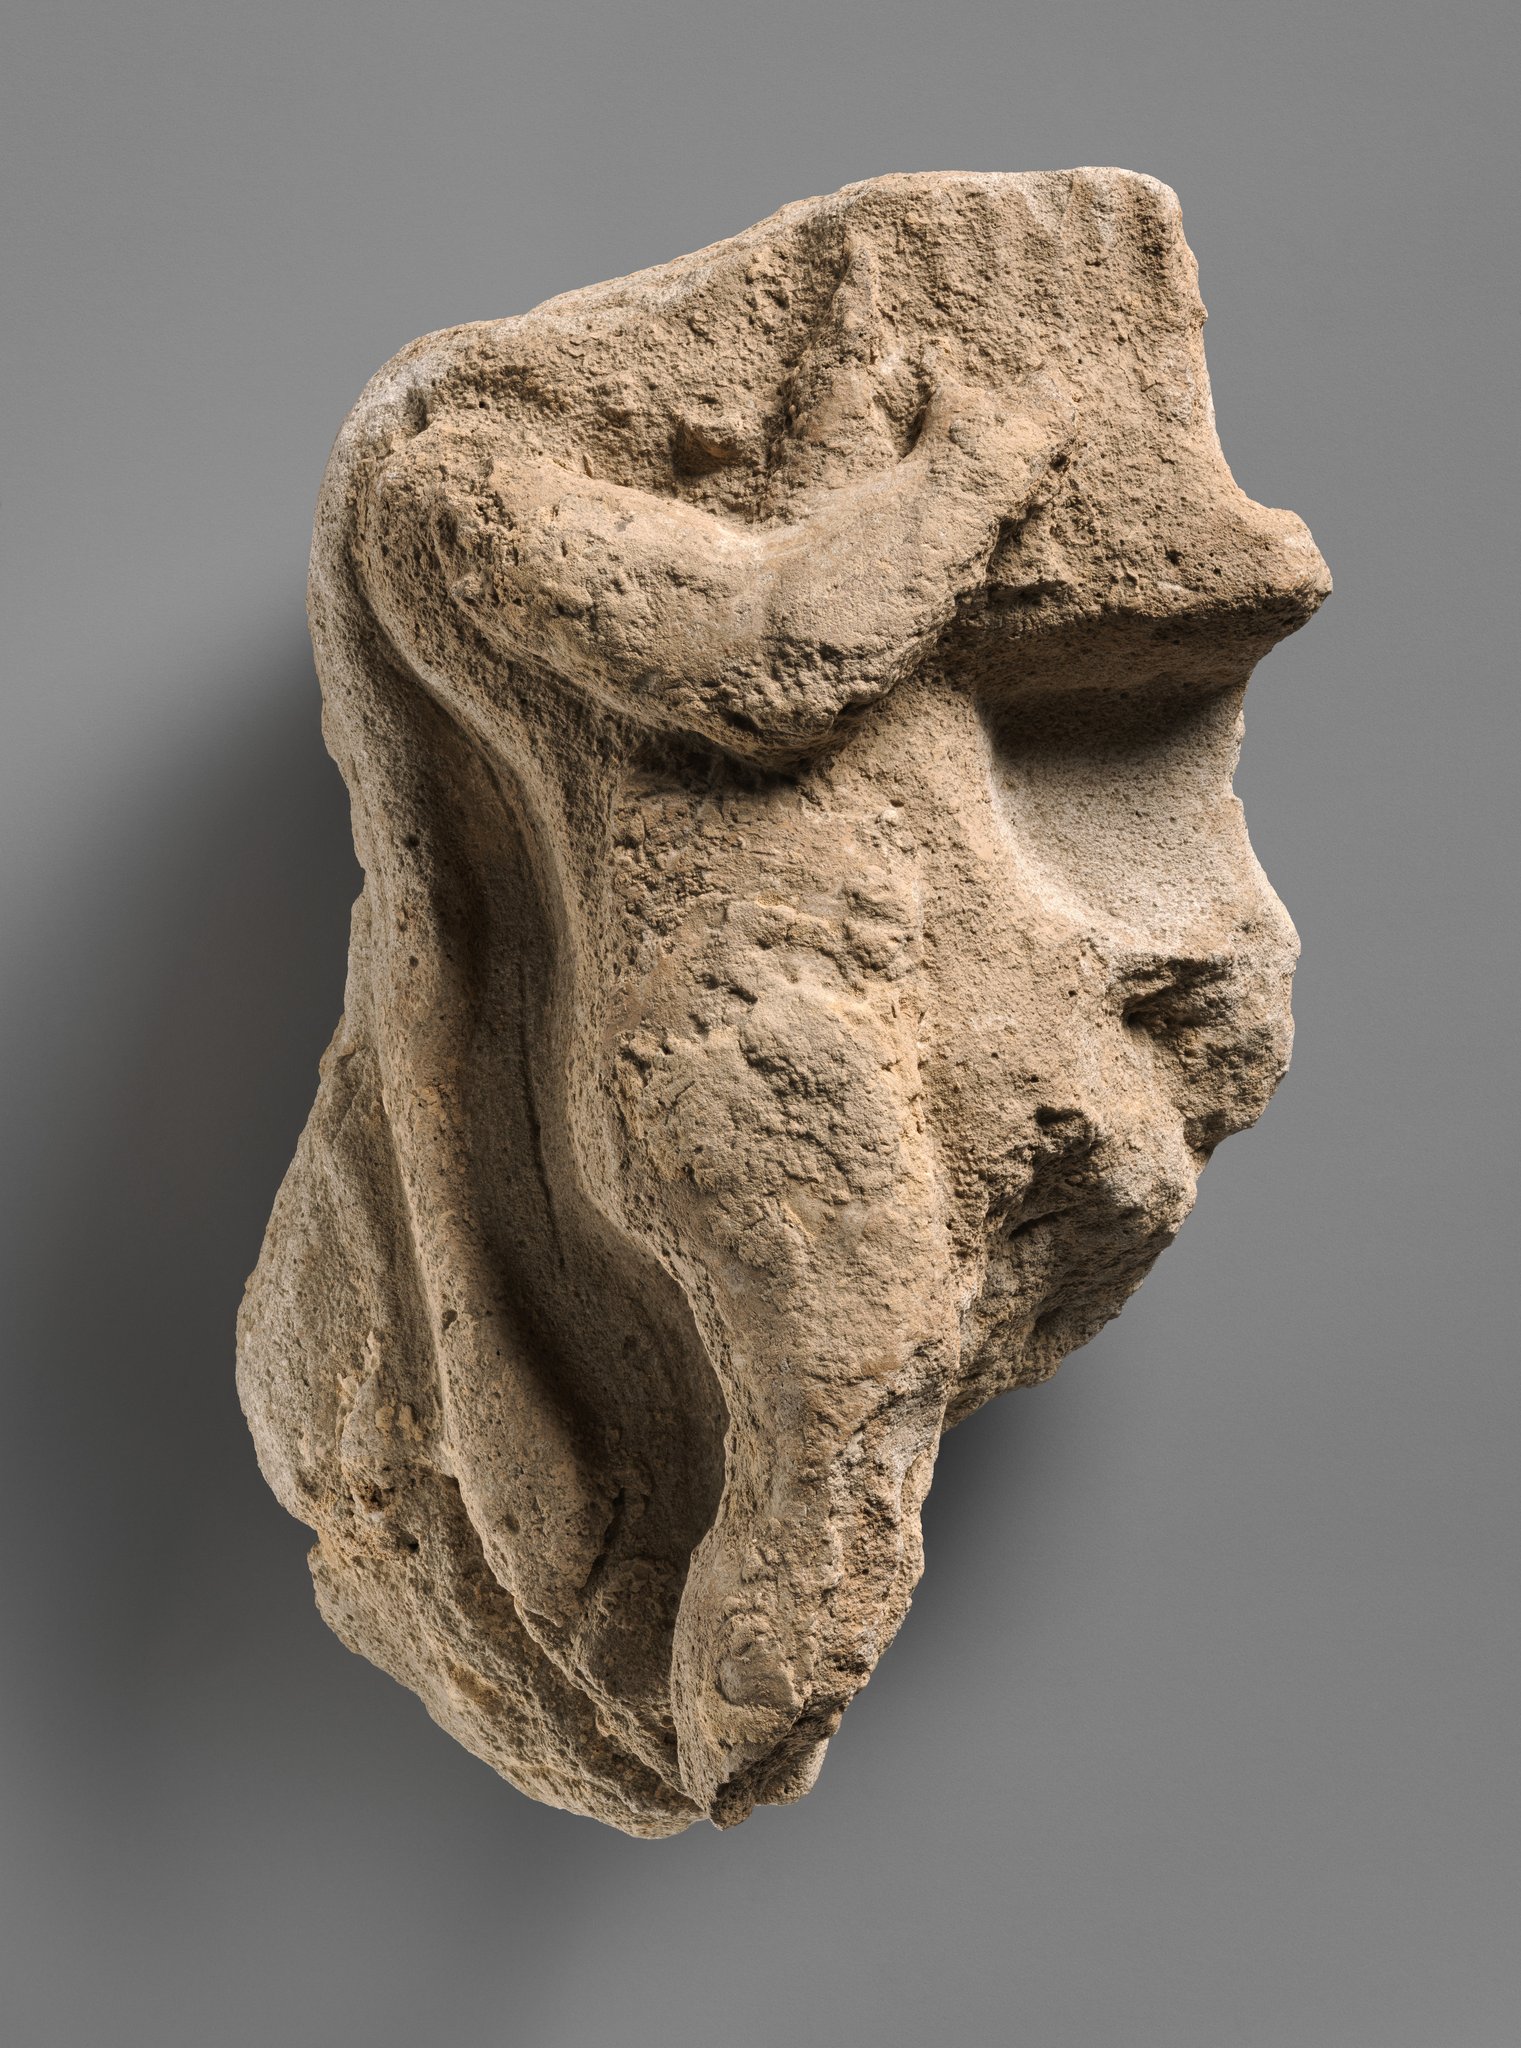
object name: relief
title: Fragment of a wall decoration with a figure playing a harp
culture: sasanian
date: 501-600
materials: plaster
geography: mesopotamia